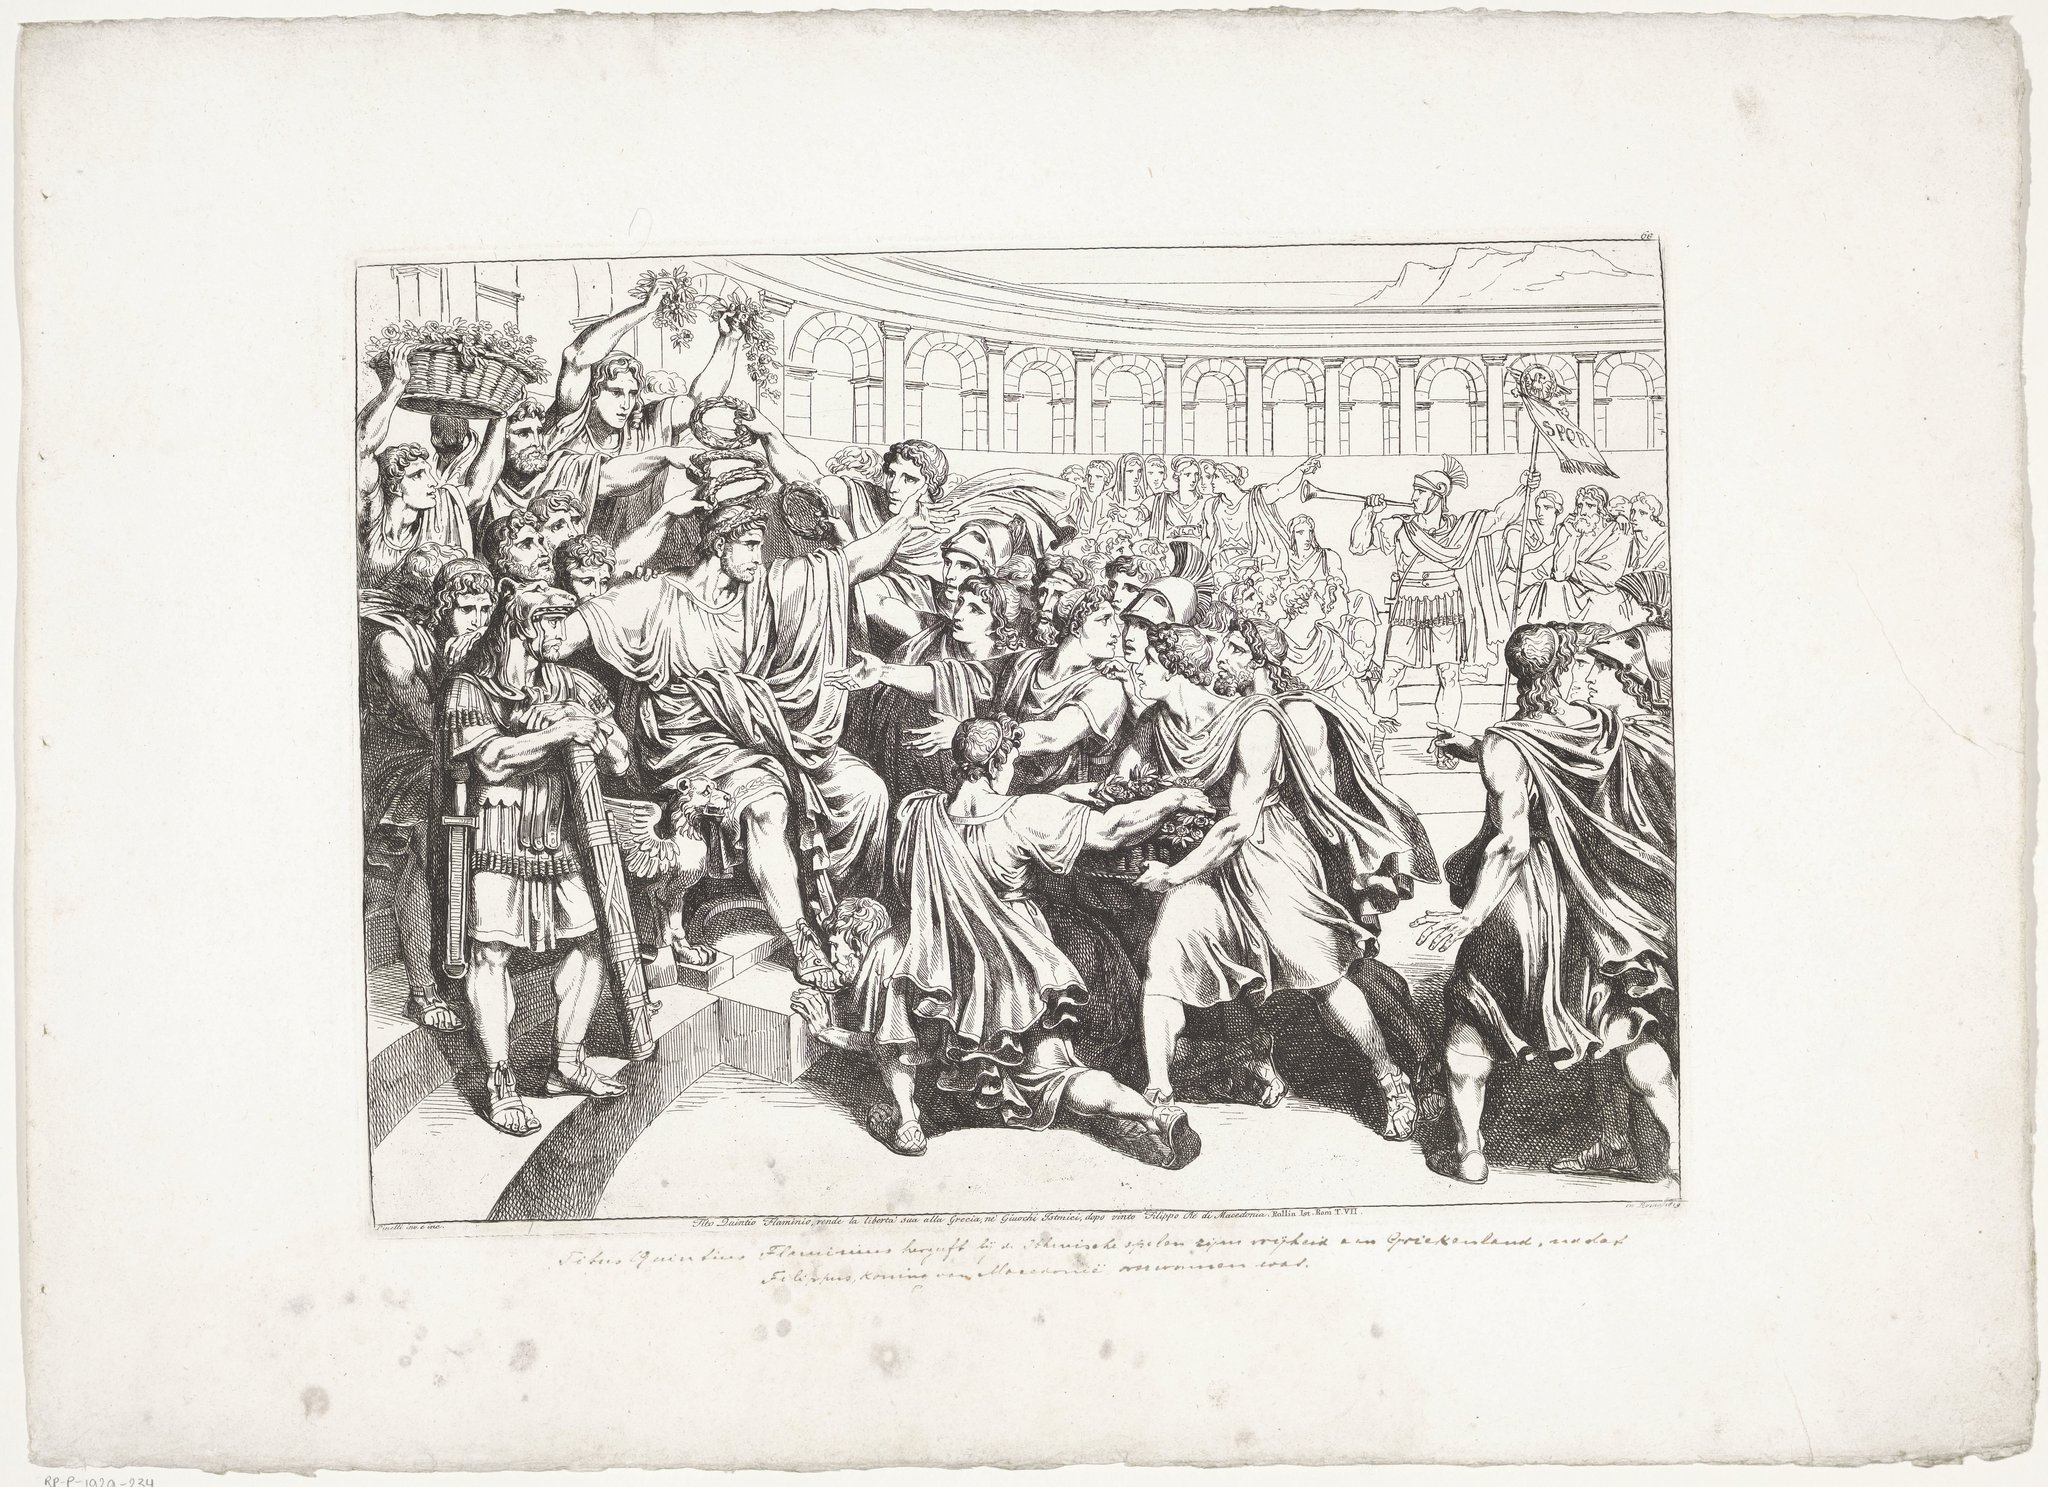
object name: print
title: Tito Quintio Flaminio, rende la libertà sua alla Grecia, né Giuochi Istmici, dopo vinto Filippo Ré di Macedonia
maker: bartolomeo pinelli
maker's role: draughtsman, print maker, sculptor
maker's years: 1781-1835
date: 1819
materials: paper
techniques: etching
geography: rome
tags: history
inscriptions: collector's mark: Lugt 2228, inscription: ‘Titus Quintius Flaminius hergeeft bij de [...]ische spelen zijne vrijheid aan Griekenland, zoodat / Filippus Koning van Macedonië overwonnen was.’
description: Titus Quinctius Flamininus proclameert tijdens de Isthmische Spelen van 196 namens de Romeinse Senaat de “vrijheid van alle Grieken, die hij van het Macedonische juk had bevrijd”. Hij wordt door de Grieken met eerbewijzen overladen.